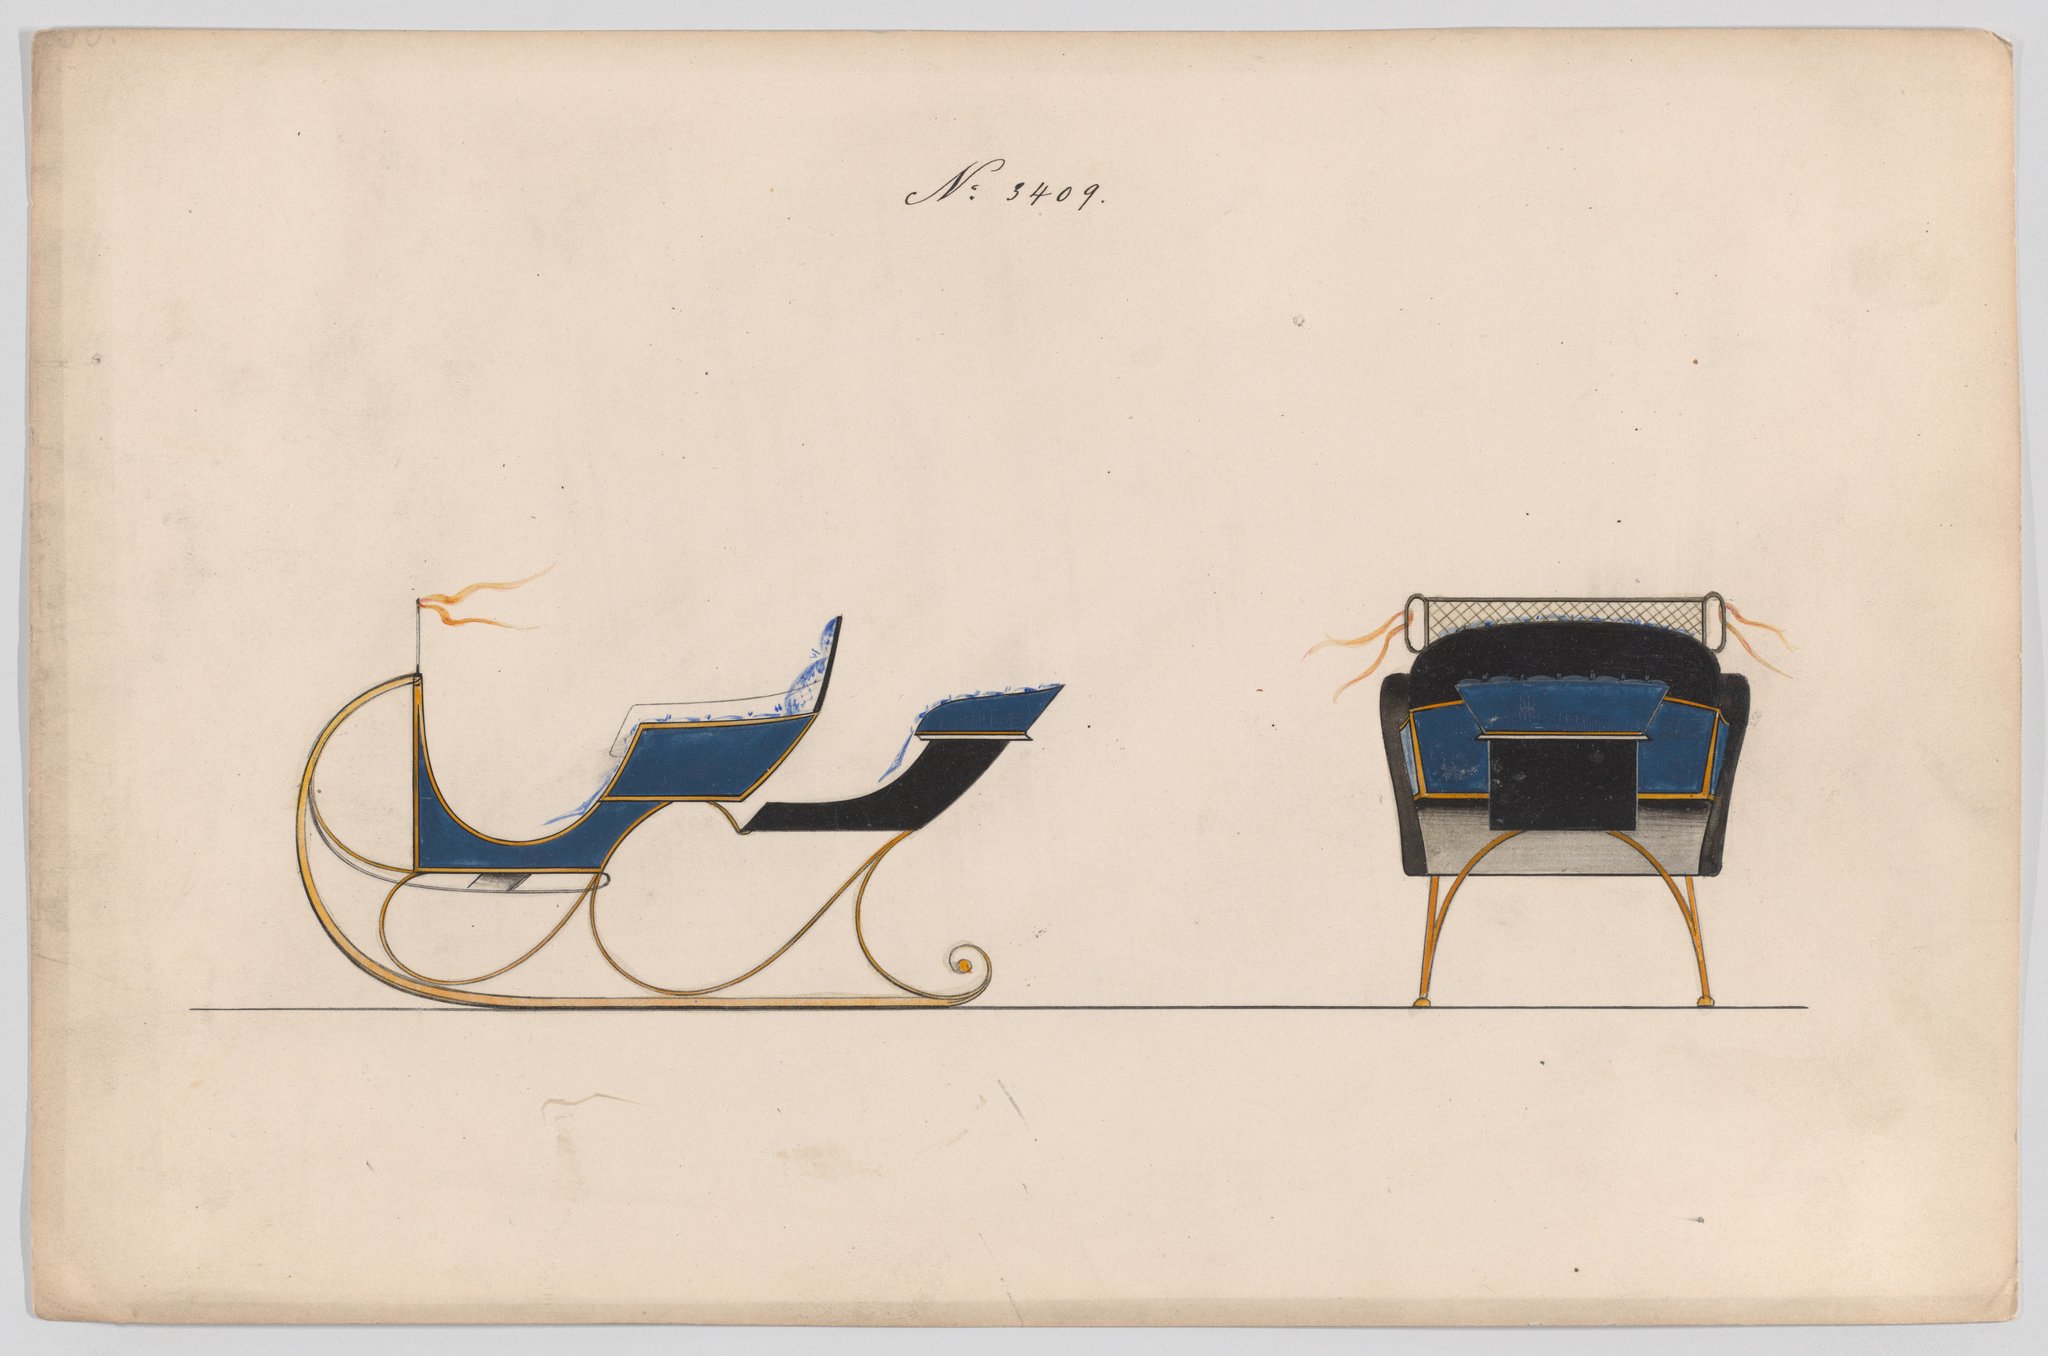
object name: drawing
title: Design for Rumble Sleigh, no. 3409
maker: brewster & co.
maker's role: manufacturer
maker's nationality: american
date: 1878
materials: gouache, gum arabic, ink, watercolor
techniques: pen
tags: sleighs